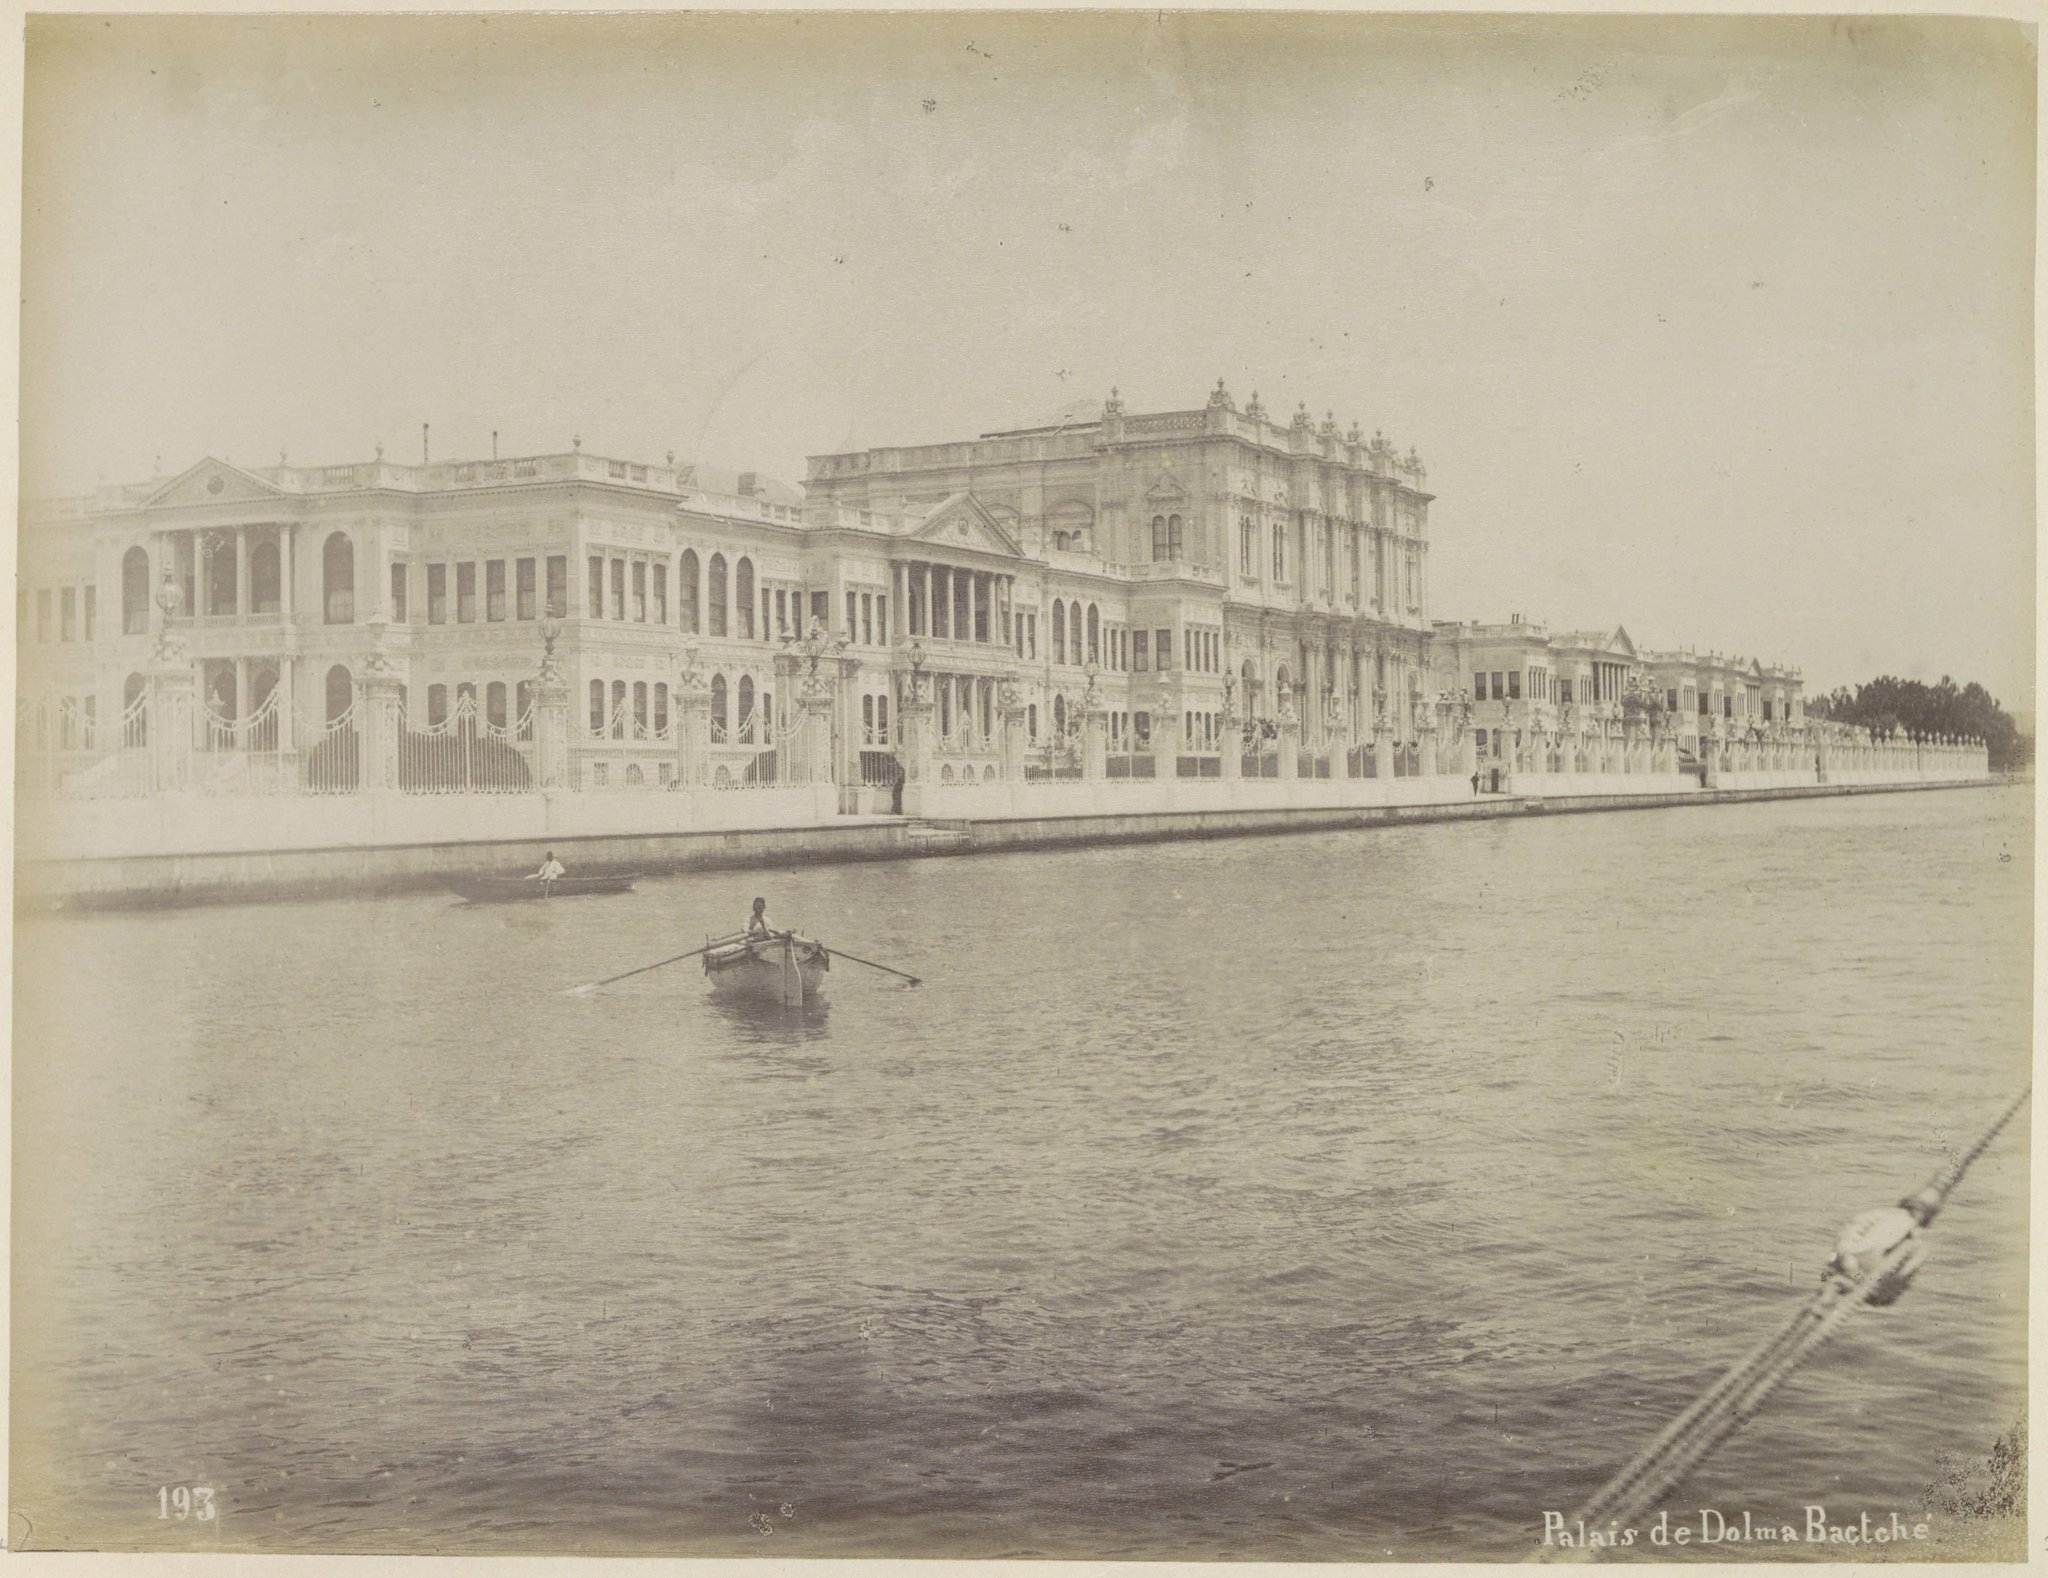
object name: photograph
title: Dolmabahçepaleis aan de Bosporus in Istanbul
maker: Anonymous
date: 1880-1890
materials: paper, photographic support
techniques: albumen print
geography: istanbul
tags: palace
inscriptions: negative number: ‘193’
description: Onderdeel van Reisalbum met foto's van bezienswaardigheden in Frankrijk, Griekenland en Turkije.